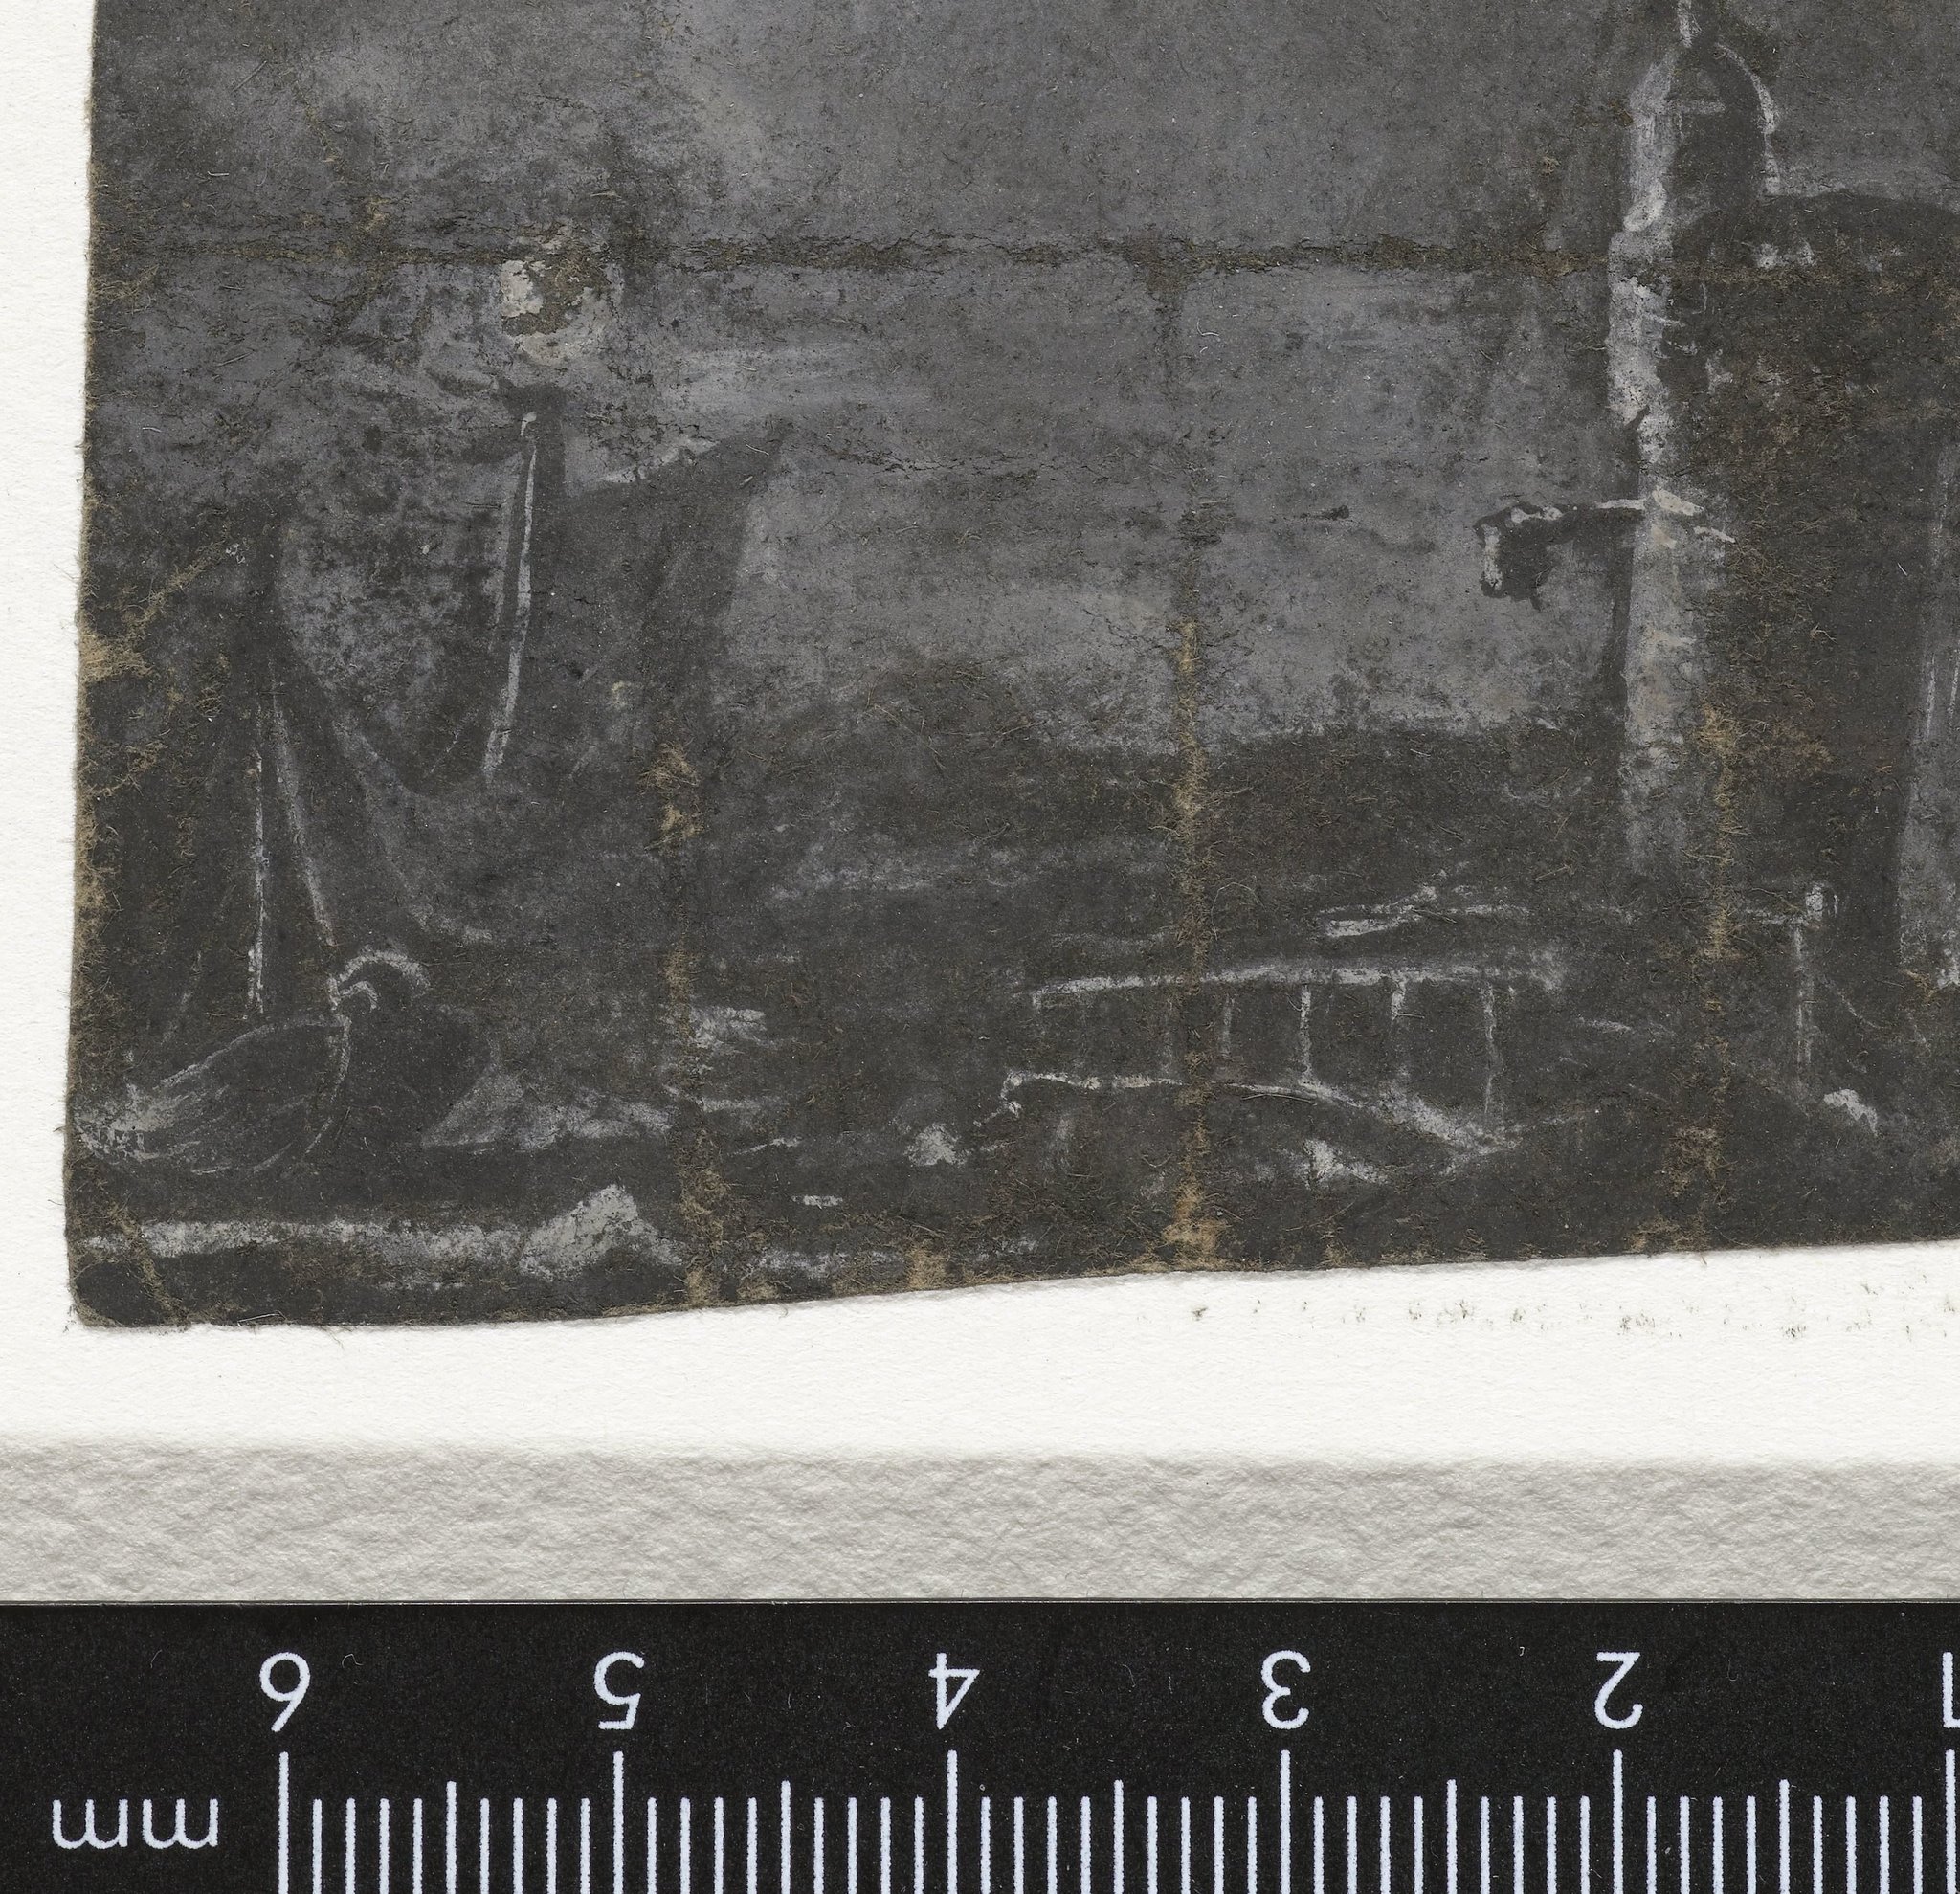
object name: drawing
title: Zeegezicht bij nacht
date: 1627-1690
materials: ink, paint, paper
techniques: brush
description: Waarschijnlijk een vroege tekening van een van de Ter Borch kinderen.